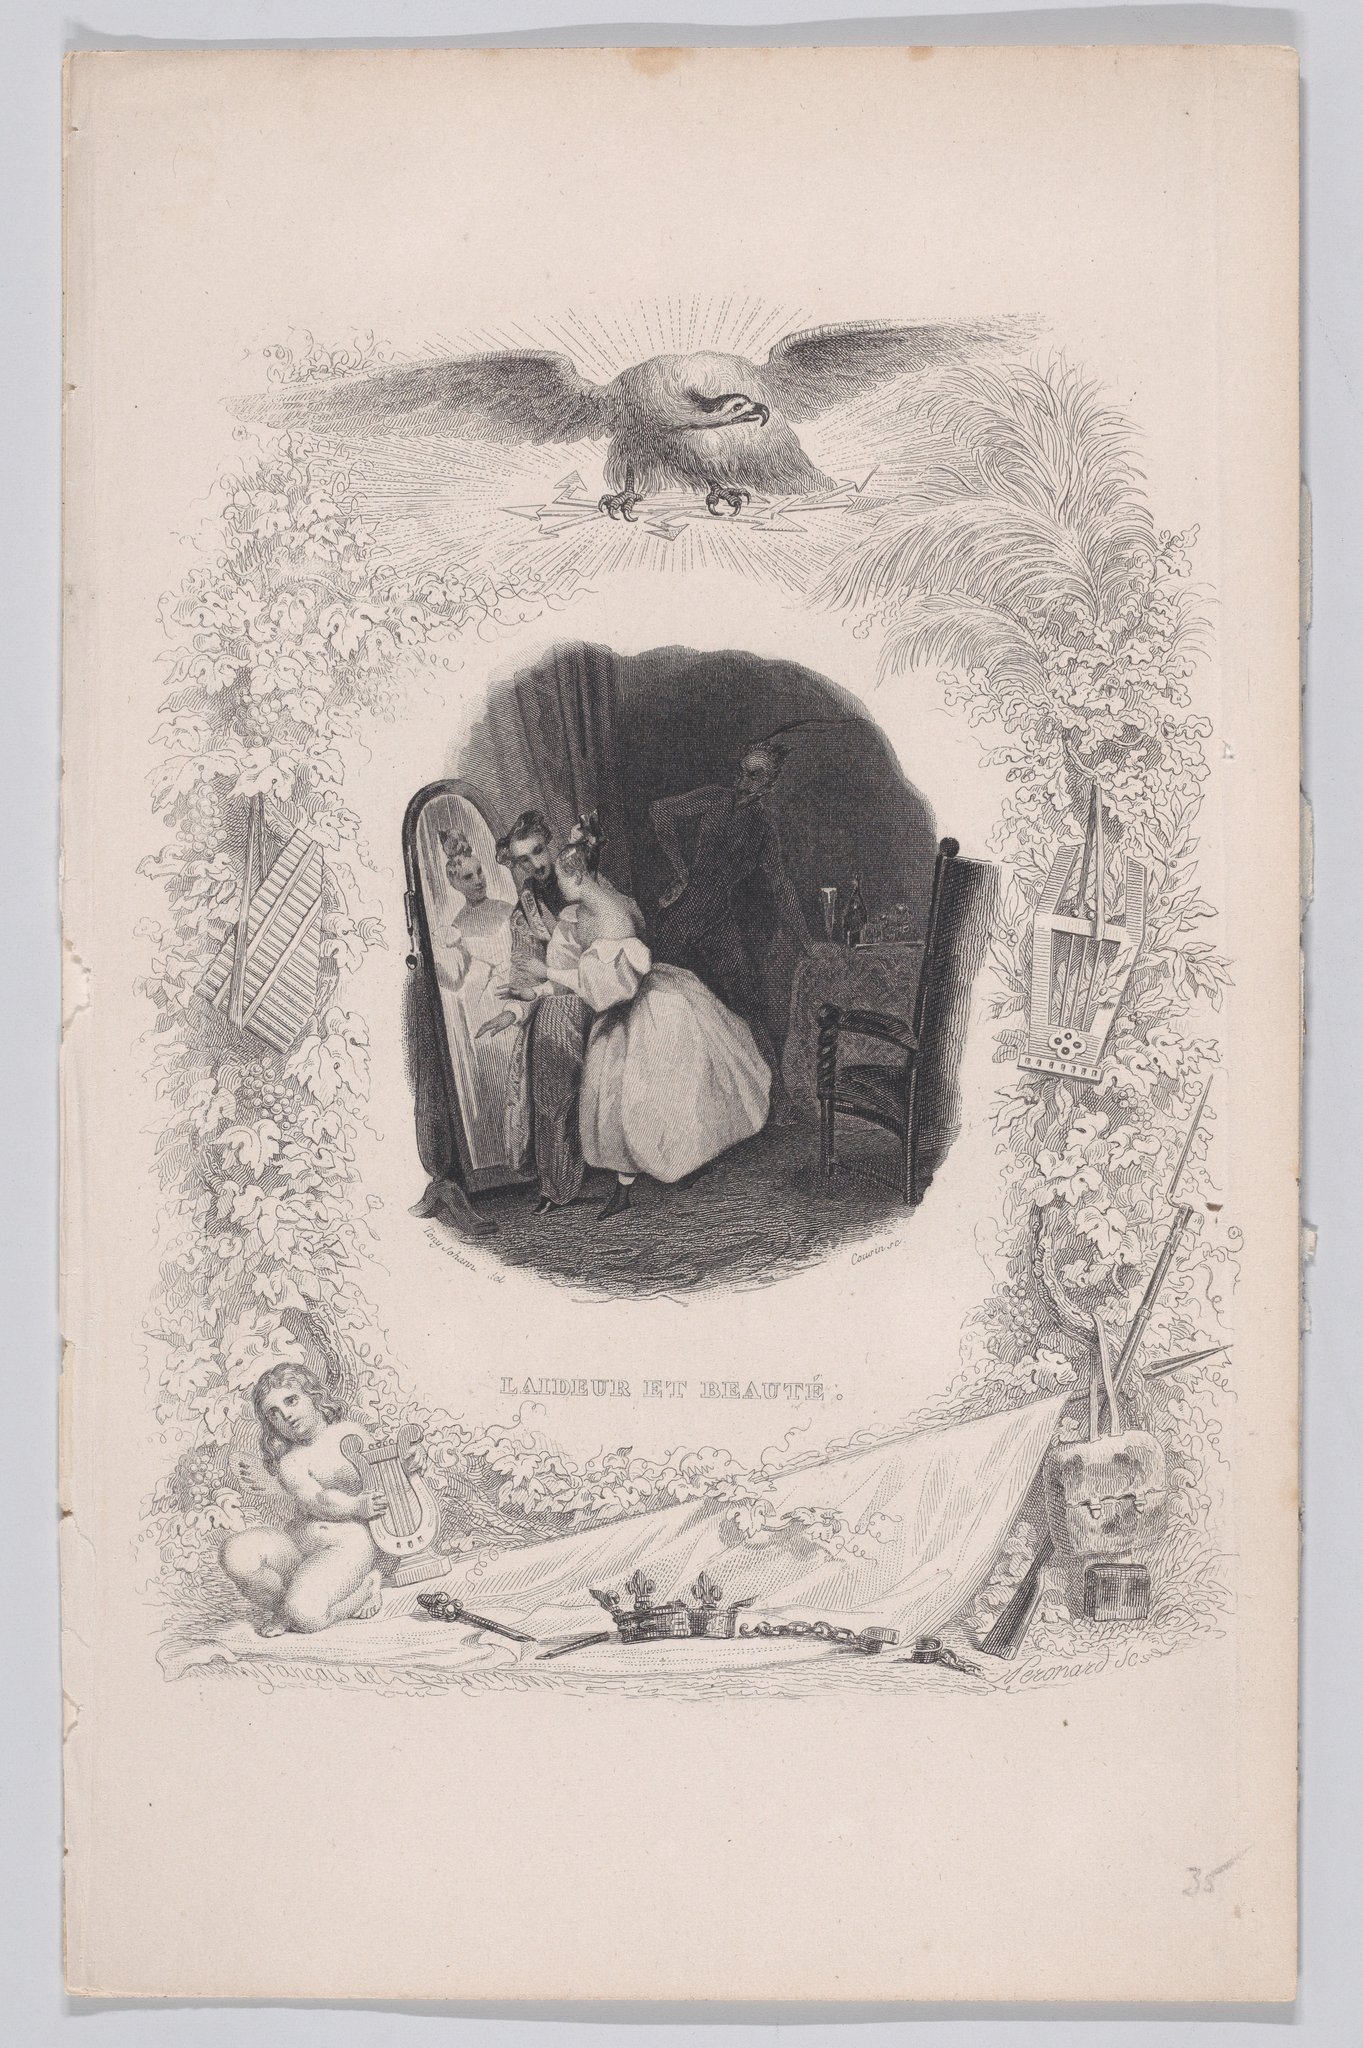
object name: print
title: Ugliness and Beauty, from "The Songs of Béranger"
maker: tony johannot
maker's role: designer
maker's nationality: french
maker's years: 1803-1852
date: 1829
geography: paris